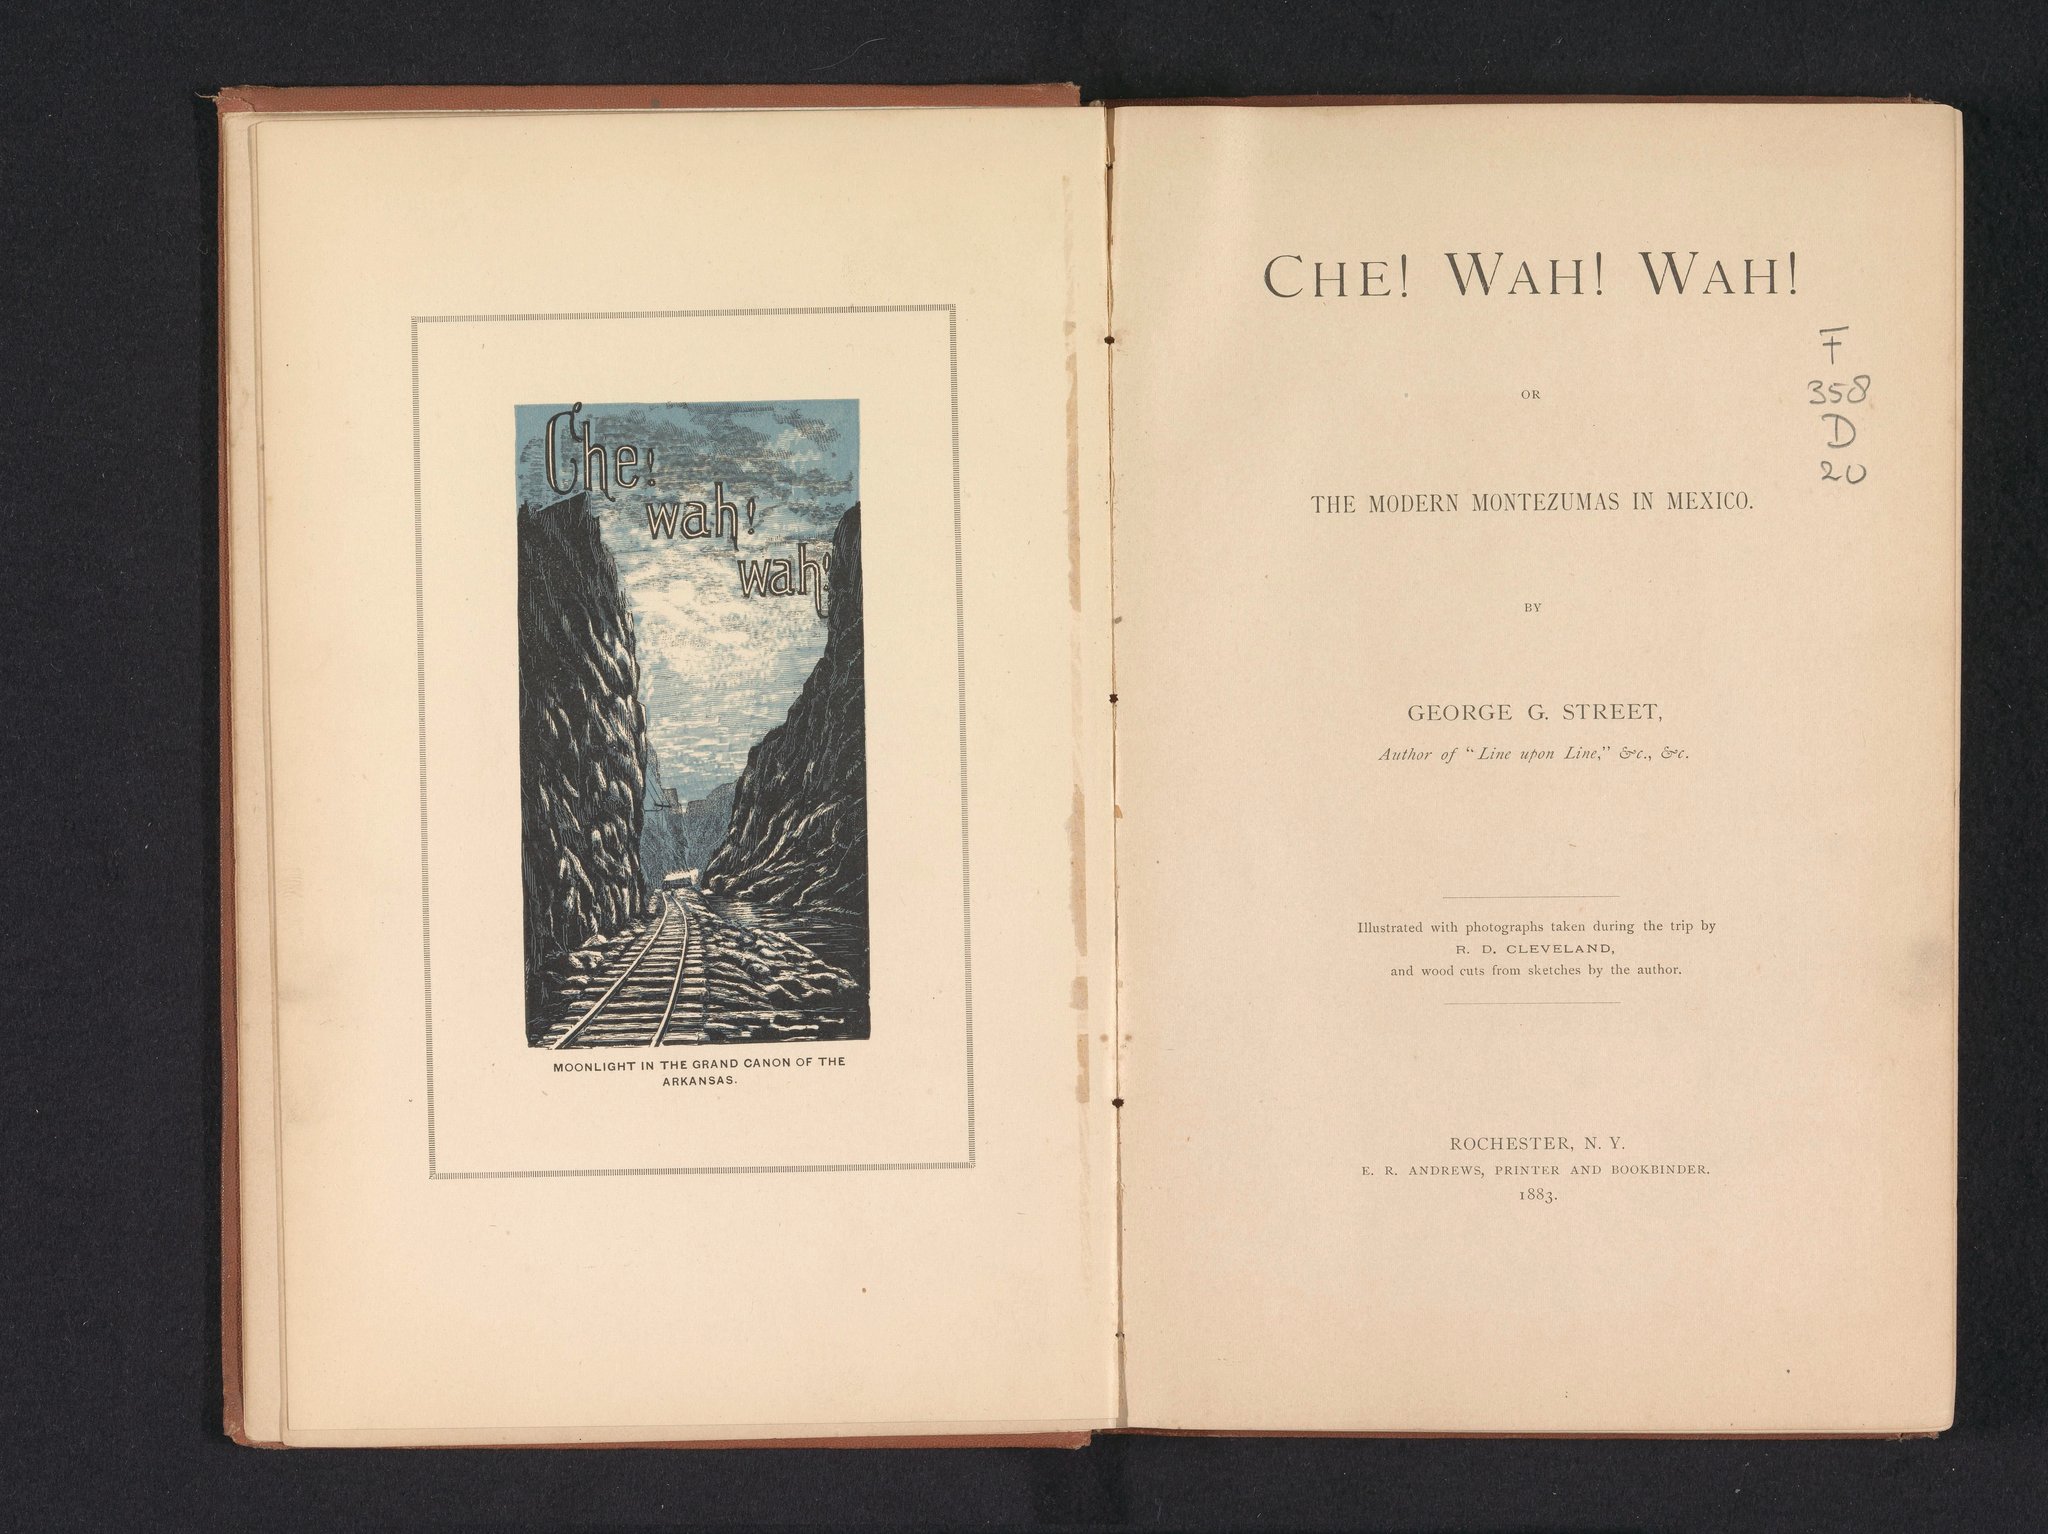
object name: book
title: Che! Wah! Wah! or the modern Montezumas in Mexico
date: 1883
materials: cardboard, linen, paper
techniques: albumen print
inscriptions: name: ‘Mr. E. T. Low Compliments of Edward Foley’